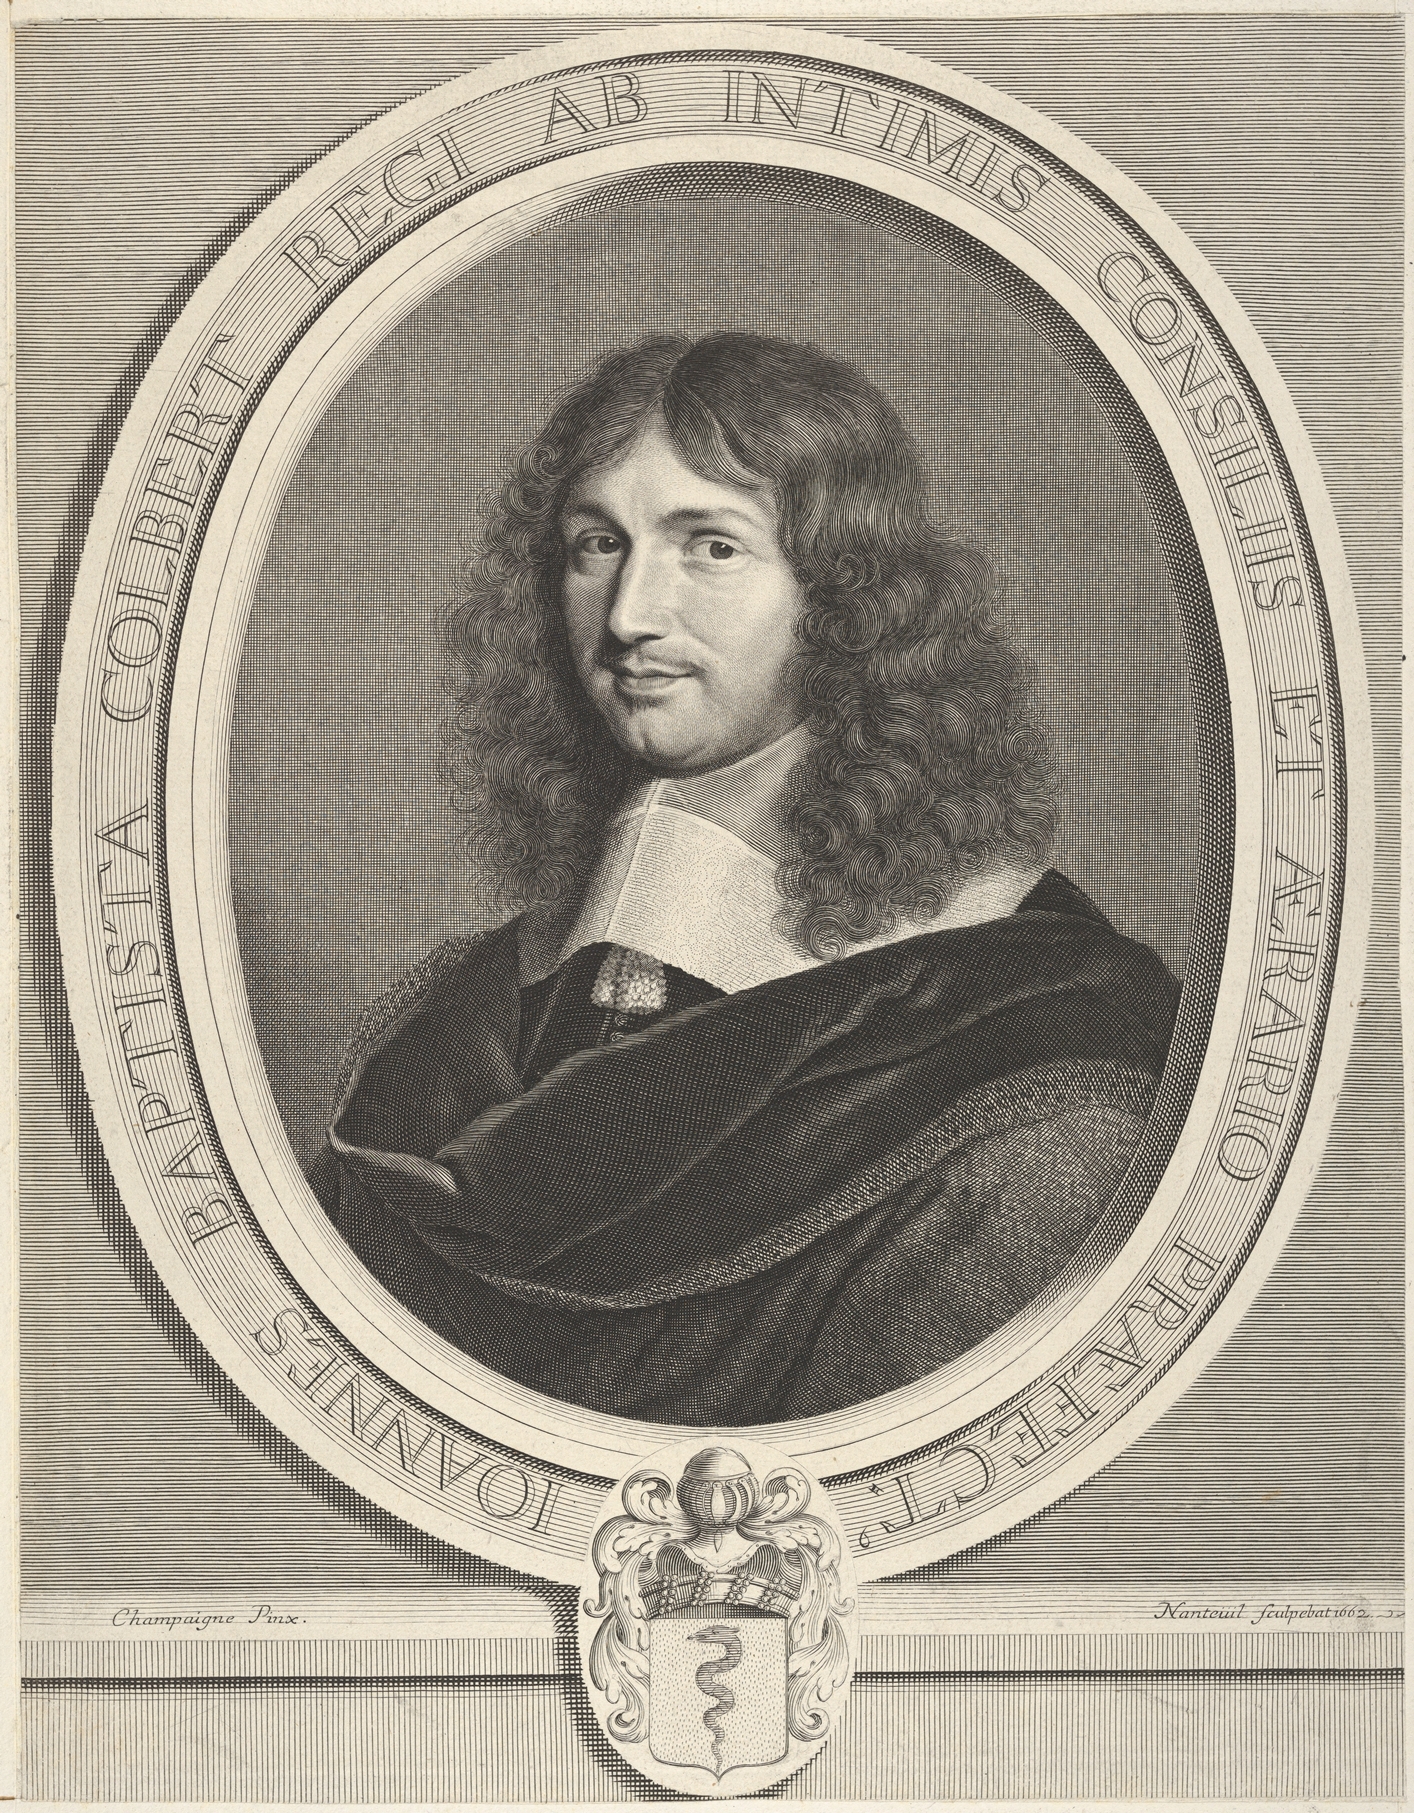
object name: print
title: Jean-Baptiste Colbert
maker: robert nanteuil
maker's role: artist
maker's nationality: french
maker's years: 1623-1678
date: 1662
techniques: engraving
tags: men,portraits